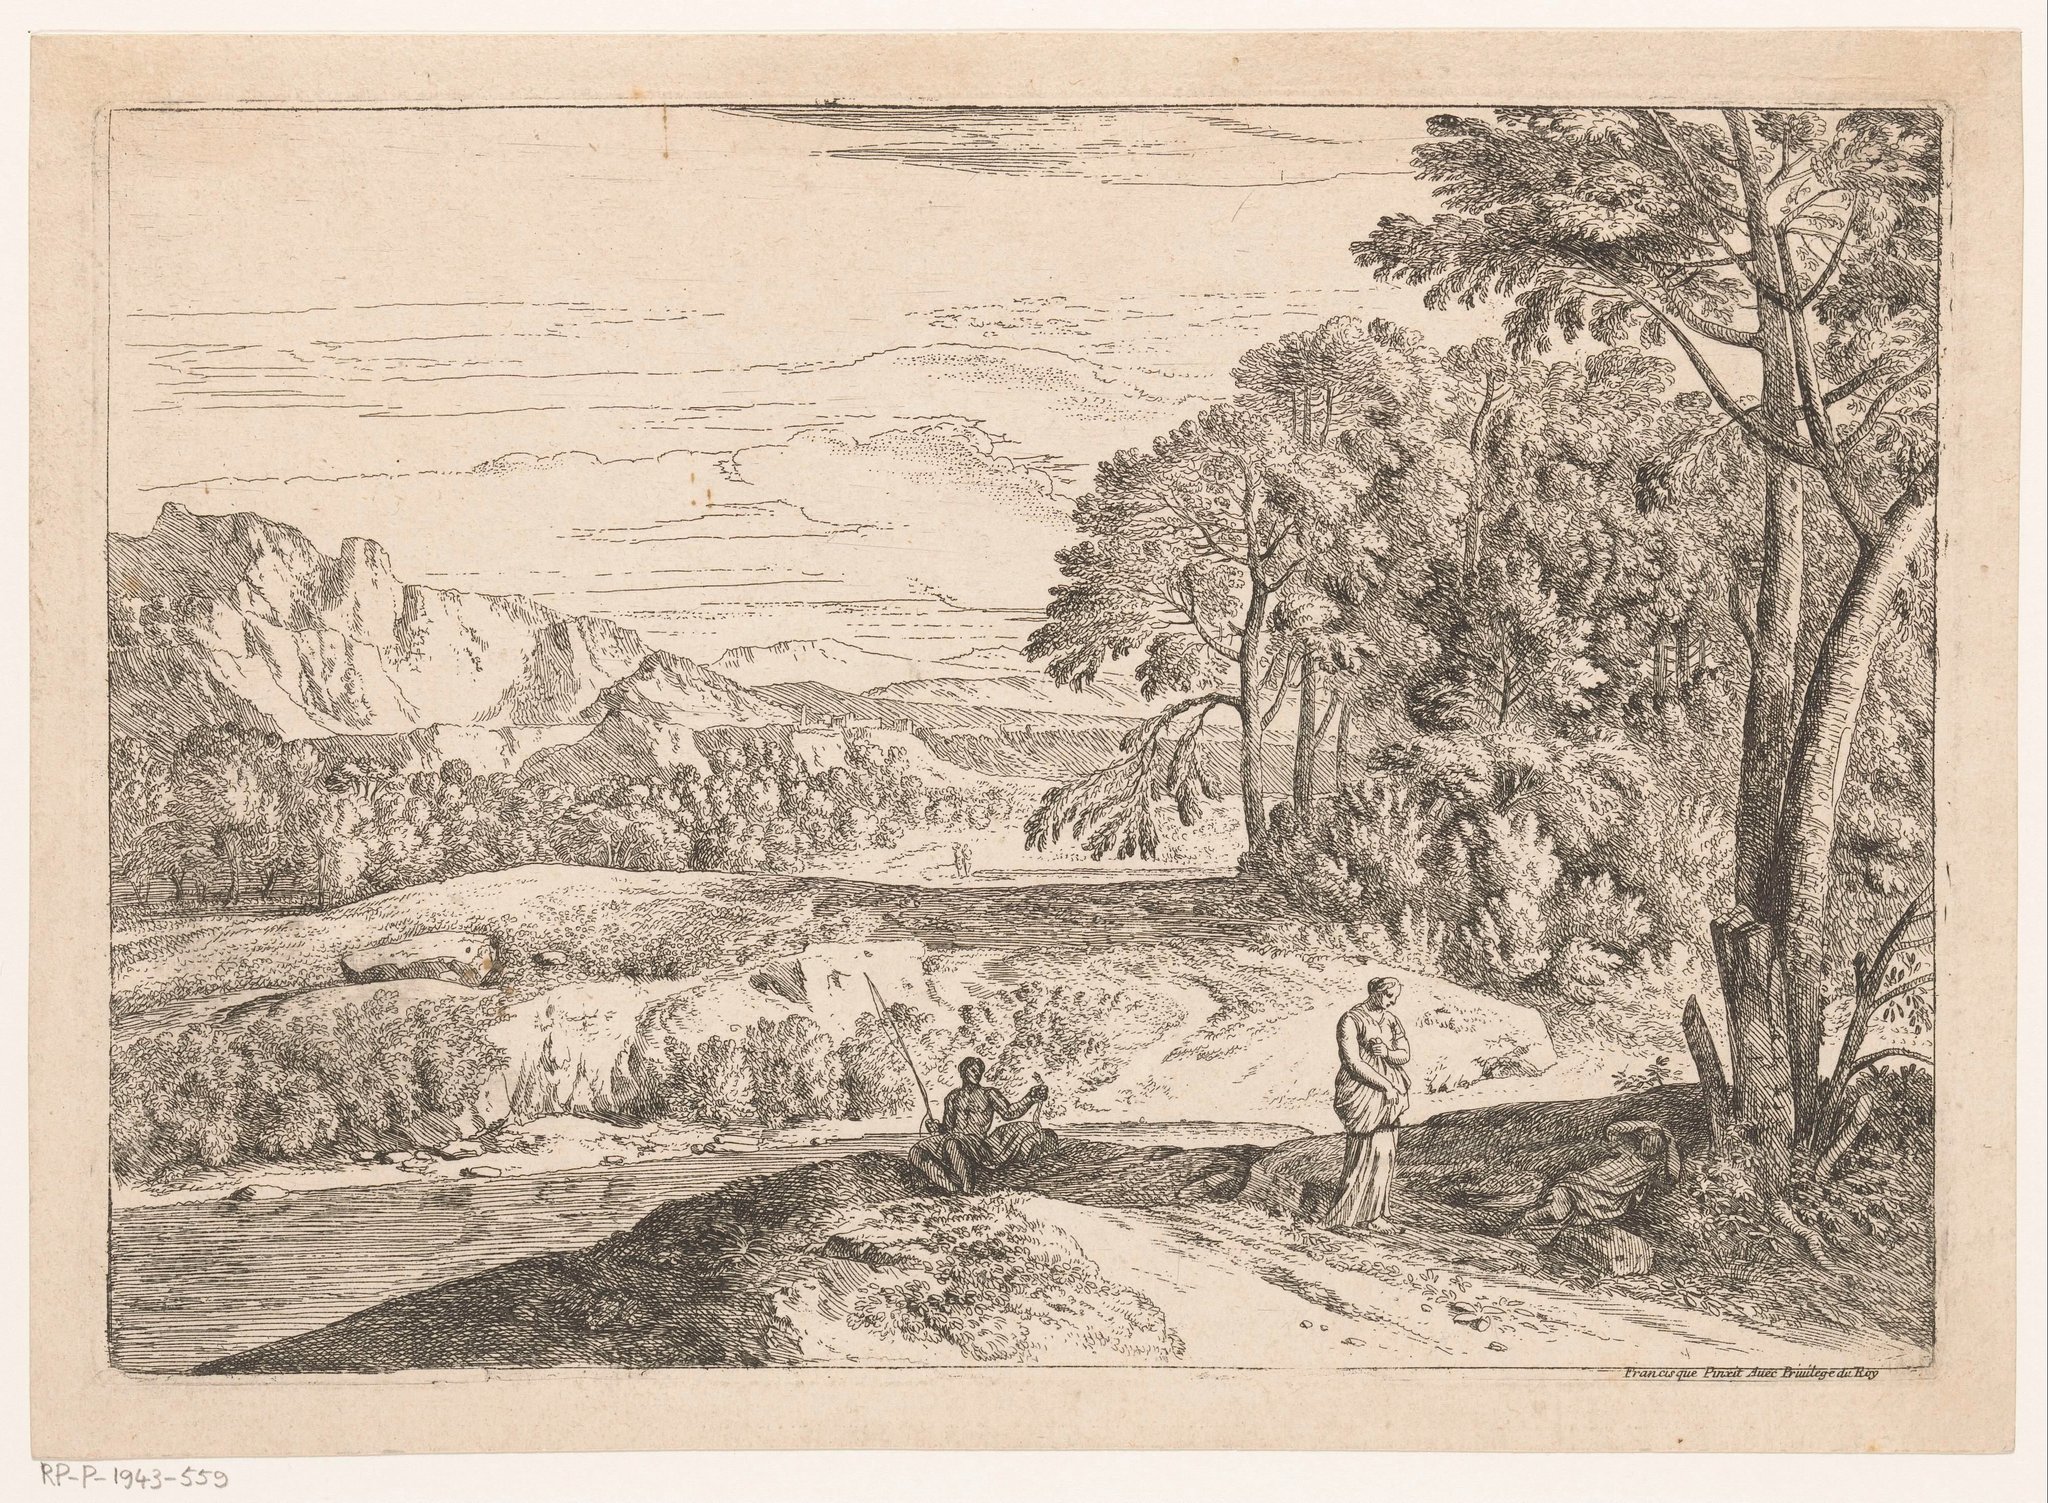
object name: print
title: Suite de Paysages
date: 1690-1730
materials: paper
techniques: etching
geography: france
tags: landscapes in the temperate zone - hh - ideal landscapes, brook, fisherman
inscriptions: collector's mark: Lugt 2228